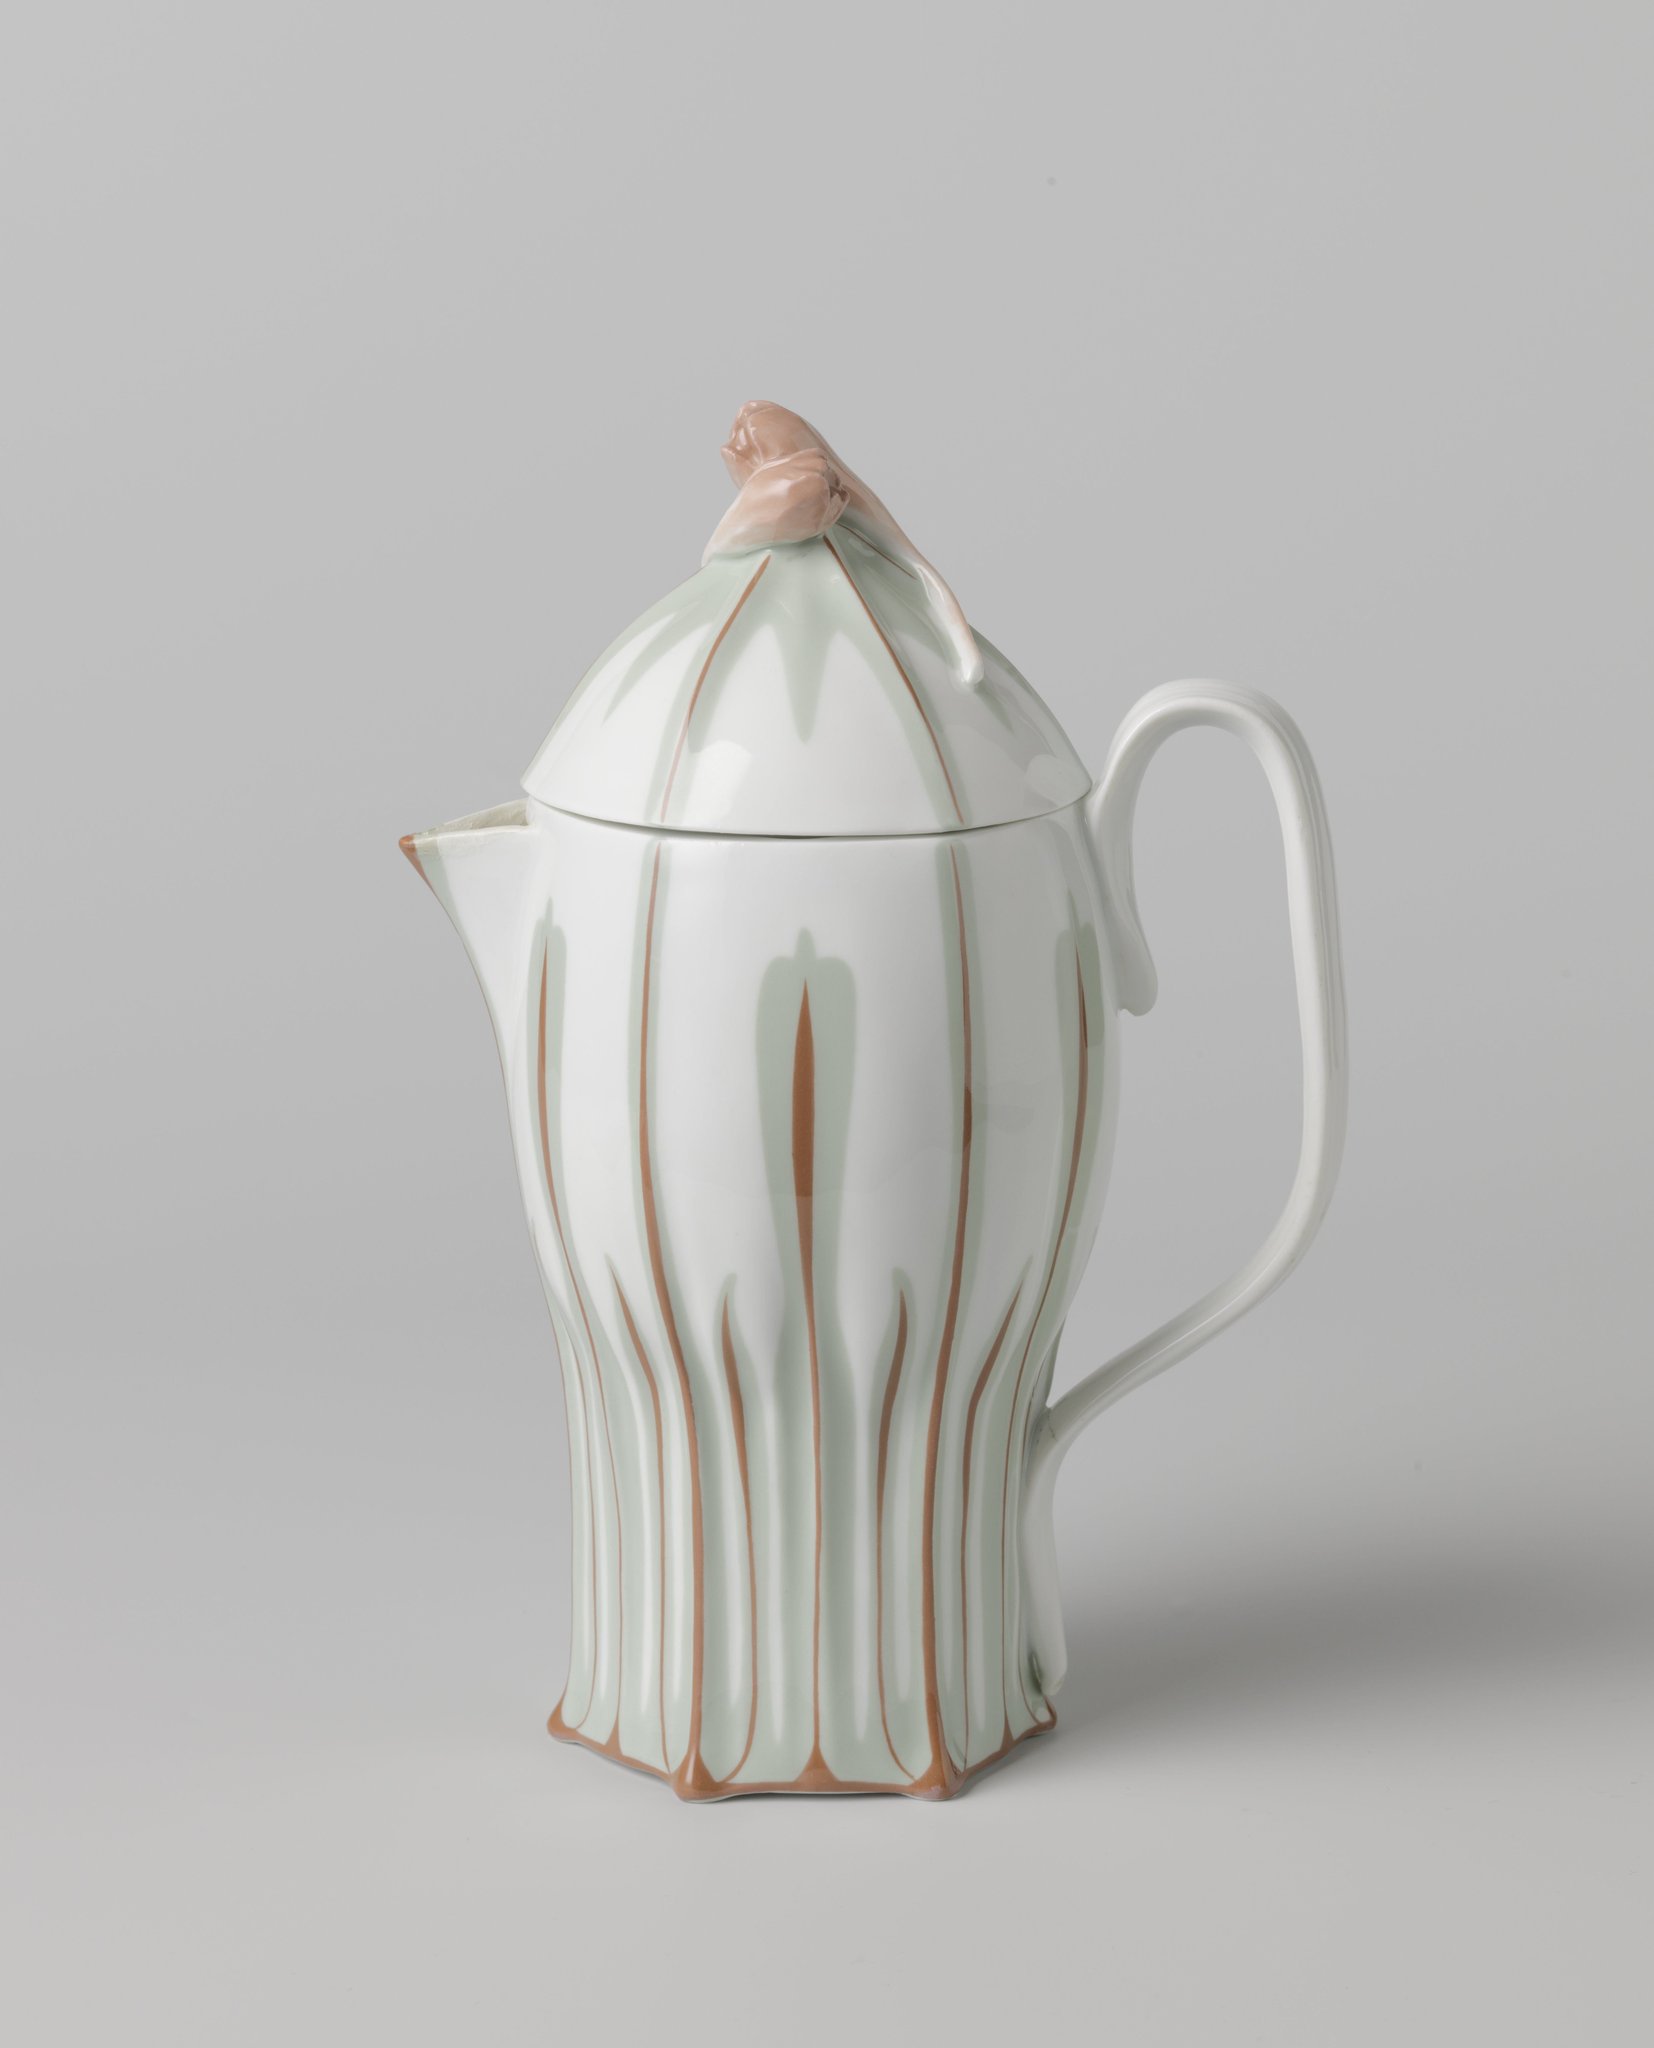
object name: eating drinking utensil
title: Koffiekan met deksel, beschilderd met het Krokus-decor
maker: konrad hentschel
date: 1896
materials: porcelain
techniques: painted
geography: meissen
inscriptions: model number: ‘Q108b’, mark: ‘52’, factory mark, mark: ‘87’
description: Parts of a coffee service. Porcelain. Meissen, Königlich Sächsische Porzellanmanufaktur, 1896, designed by Julius Konrad Hentschel.